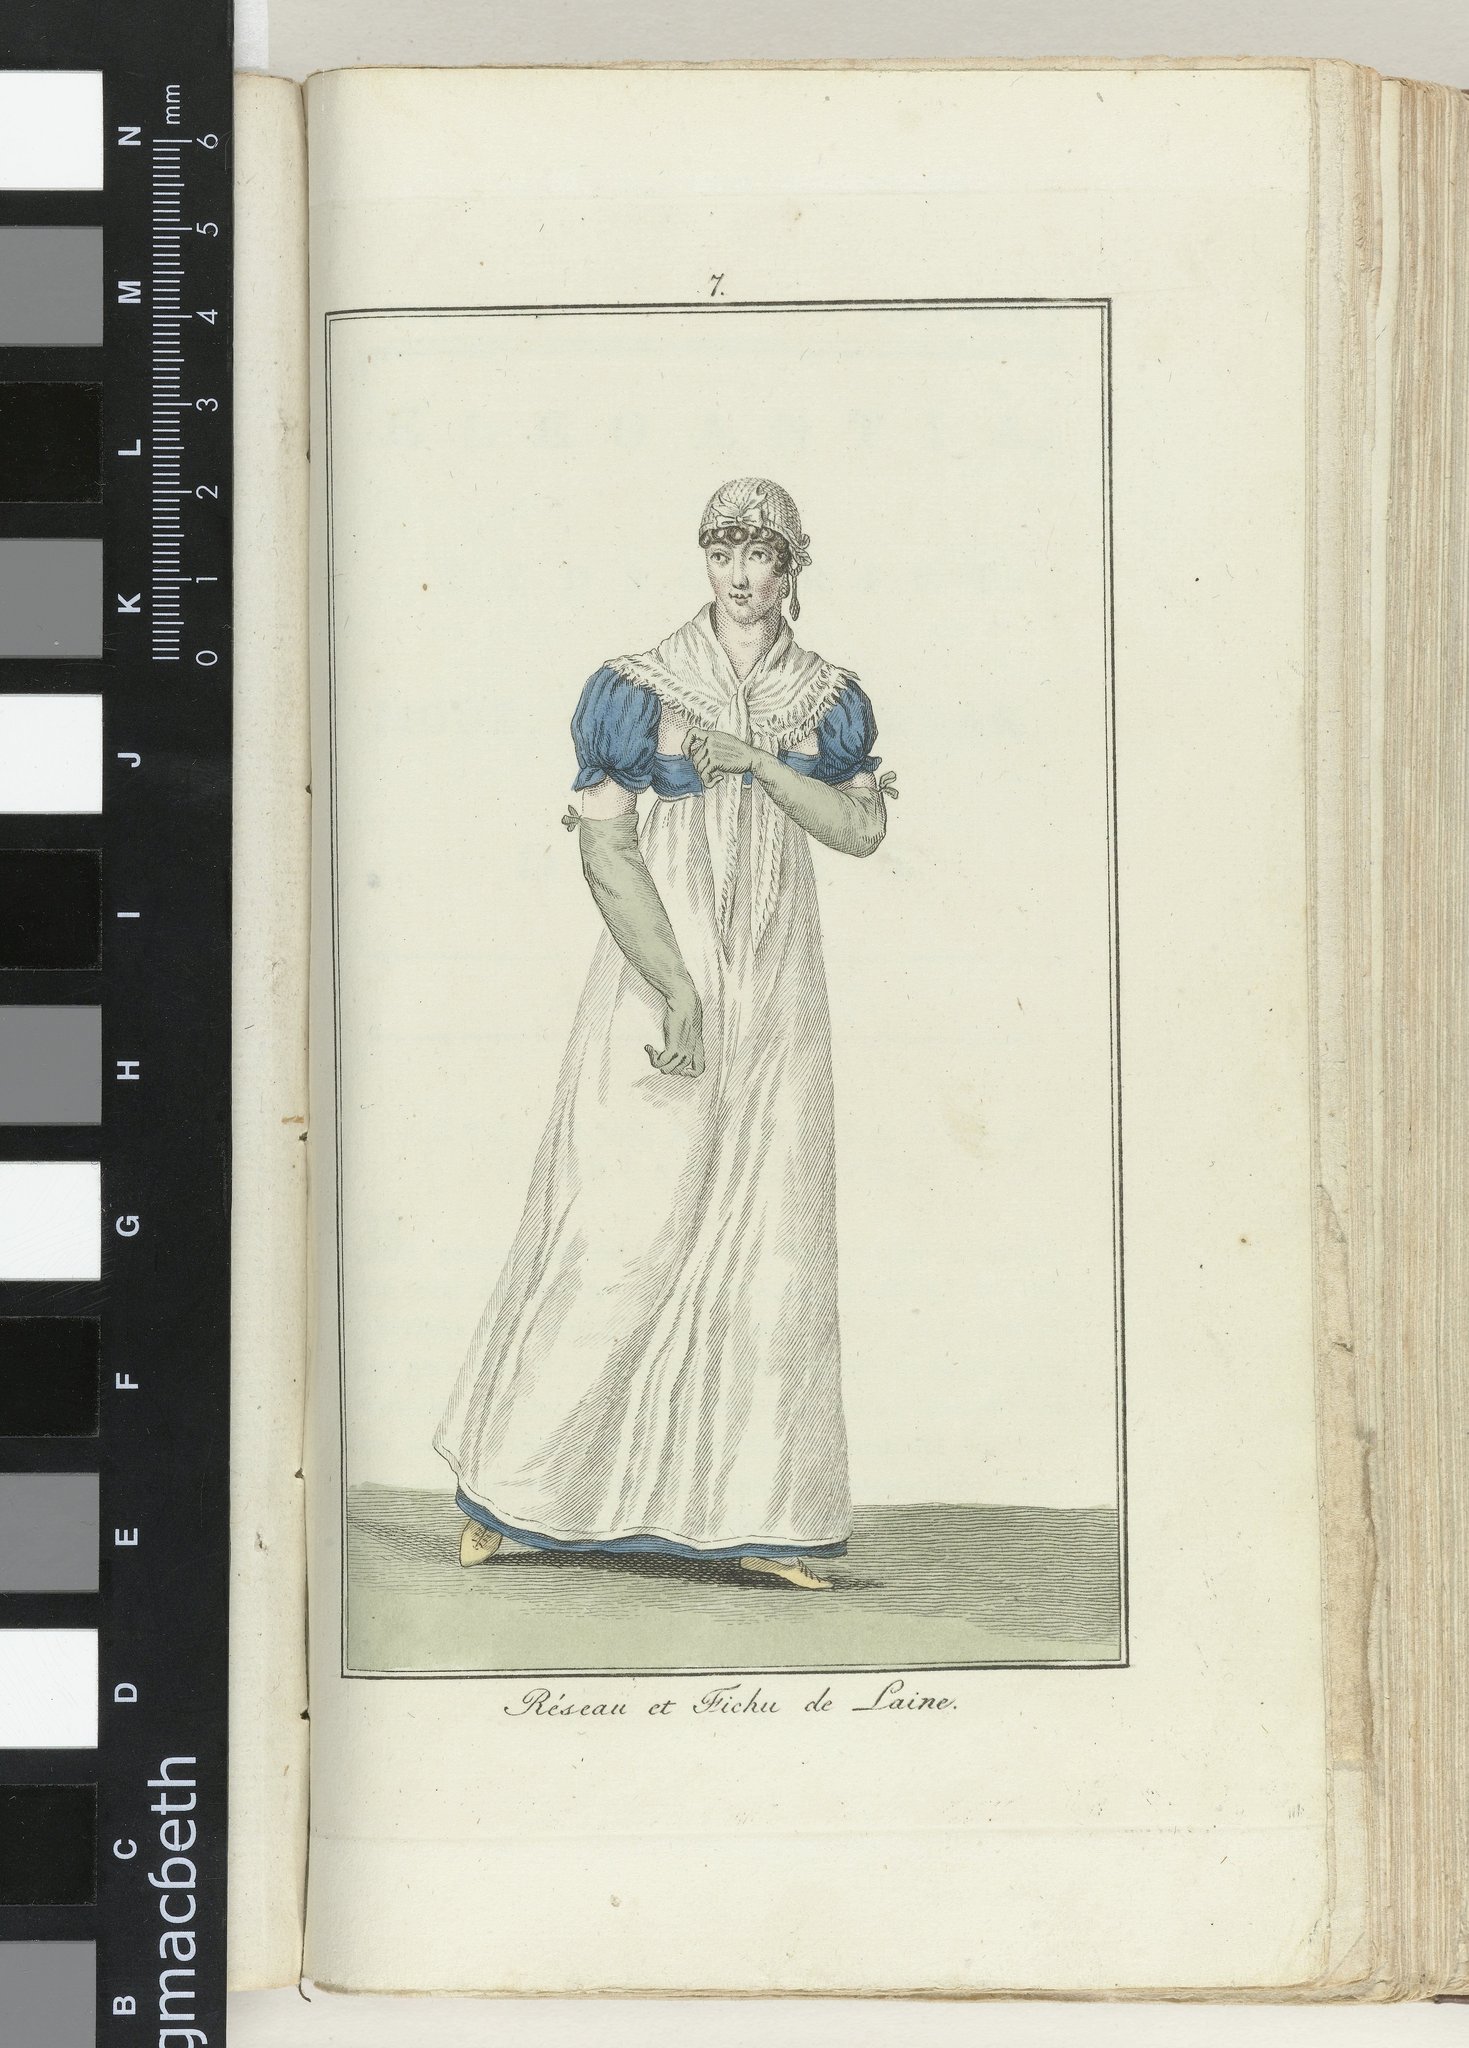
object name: fashion print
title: Elegantia, of tijdschrift van mode, luxe en smaak voor dames, Maart 1807, No. 7: Réseau et Fichu de Laine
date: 1807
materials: paper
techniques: engraving, hand coloring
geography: amsterdam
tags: gloves, mittens (long gloves) (+ women's clothes), fashion plates, dress, gown (+ women's clothes), apron (+ women's clothes), piece of clothing covering the breast or décolleté (fichu) (+ women's clothes)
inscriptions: caption: ‘Réseau et Fichu de Laine’